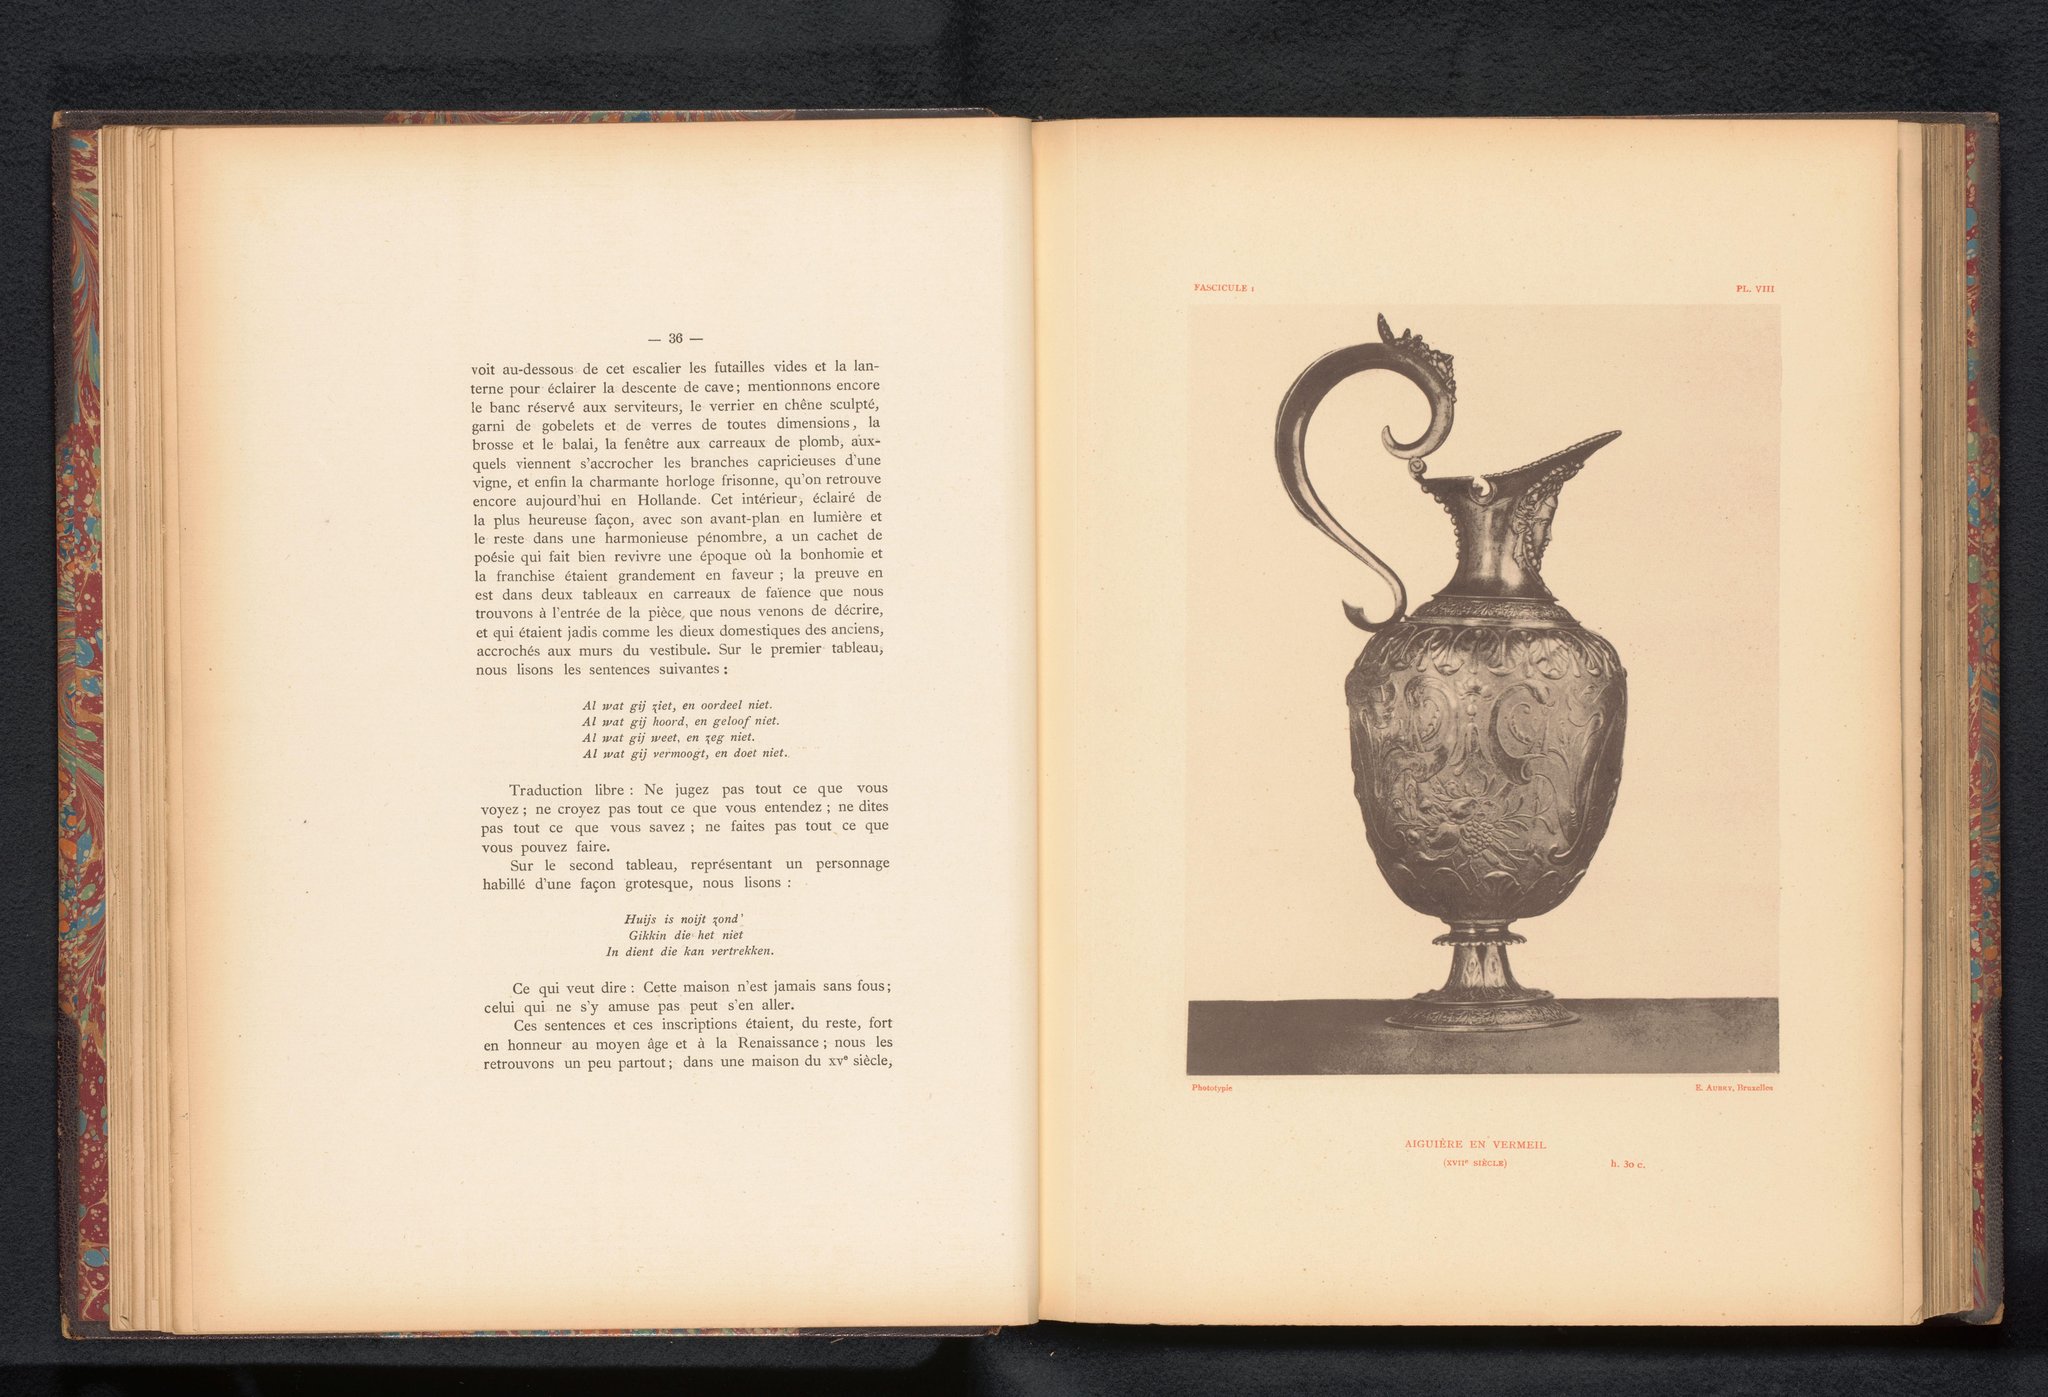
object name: page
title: Aiguière en vermeil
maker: emile aubry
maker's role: print maker, printer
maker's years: 1829-1900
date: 1878-1883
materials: paper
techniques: photograph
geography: brussels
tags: drinking-vessels, sculpture (+ relief ~ sculpture)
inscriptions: inscription: ‘Fascicule I/ PL. VIII’, inscription: ‘XVIIe siècle’